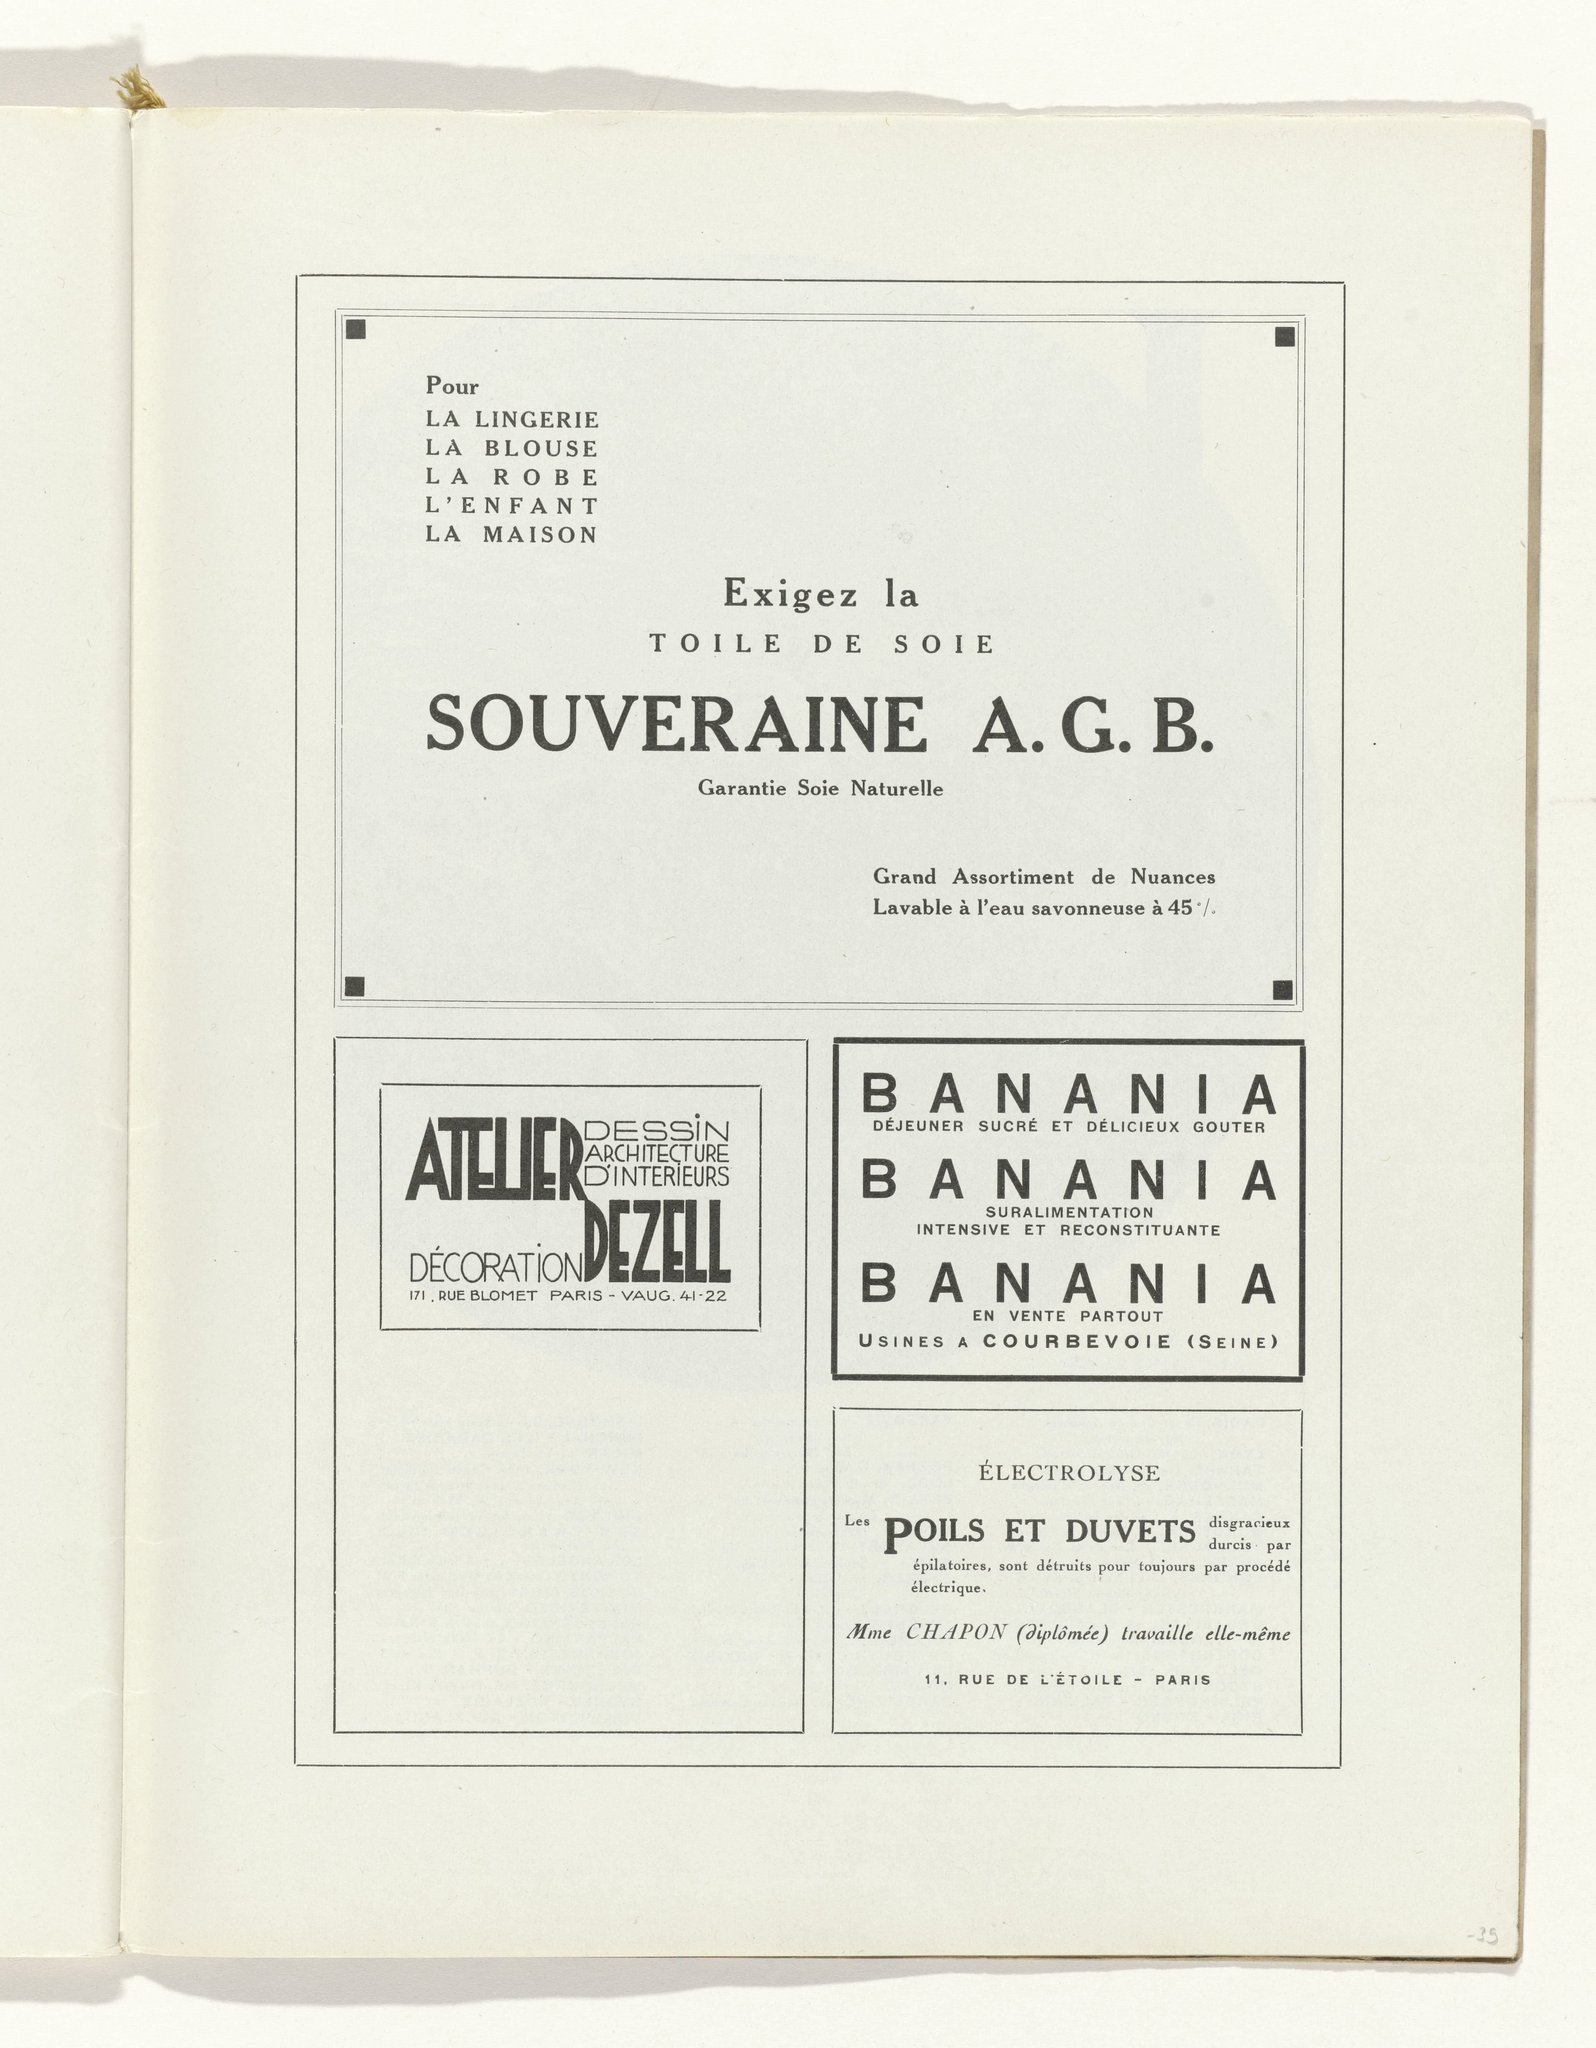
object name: magazine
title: Art - Goût - Beauté, Feuillets de l' élégance féminine, Juin 1932, No. 142, 12e Année, p. 39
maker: henri rouit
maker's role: publisher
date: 1932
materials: paper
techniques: photography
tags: fashion plates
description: Advertenties voor verschillende producten. Pagina uit het modetijdschrift Art-Goût-Beauté (1920-1933).